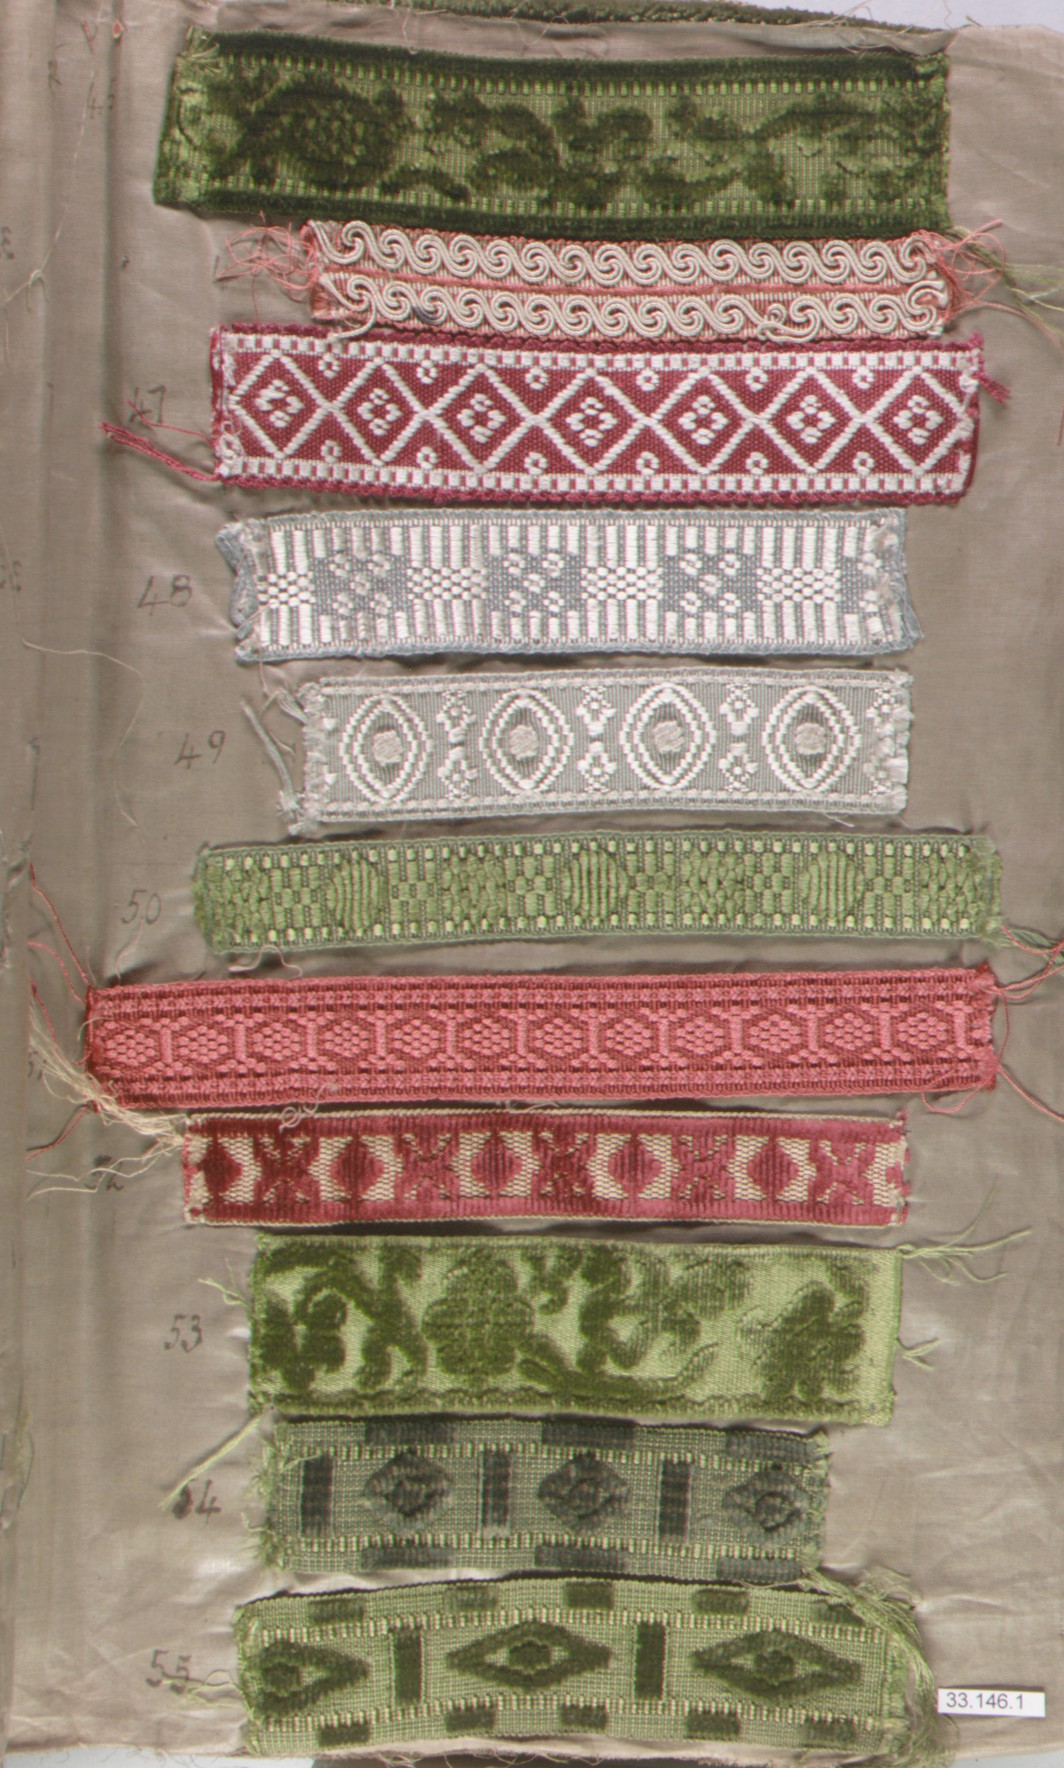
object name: sample book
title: Textile Sample Book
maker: morant and co.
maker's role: manufactory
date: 1701-1900